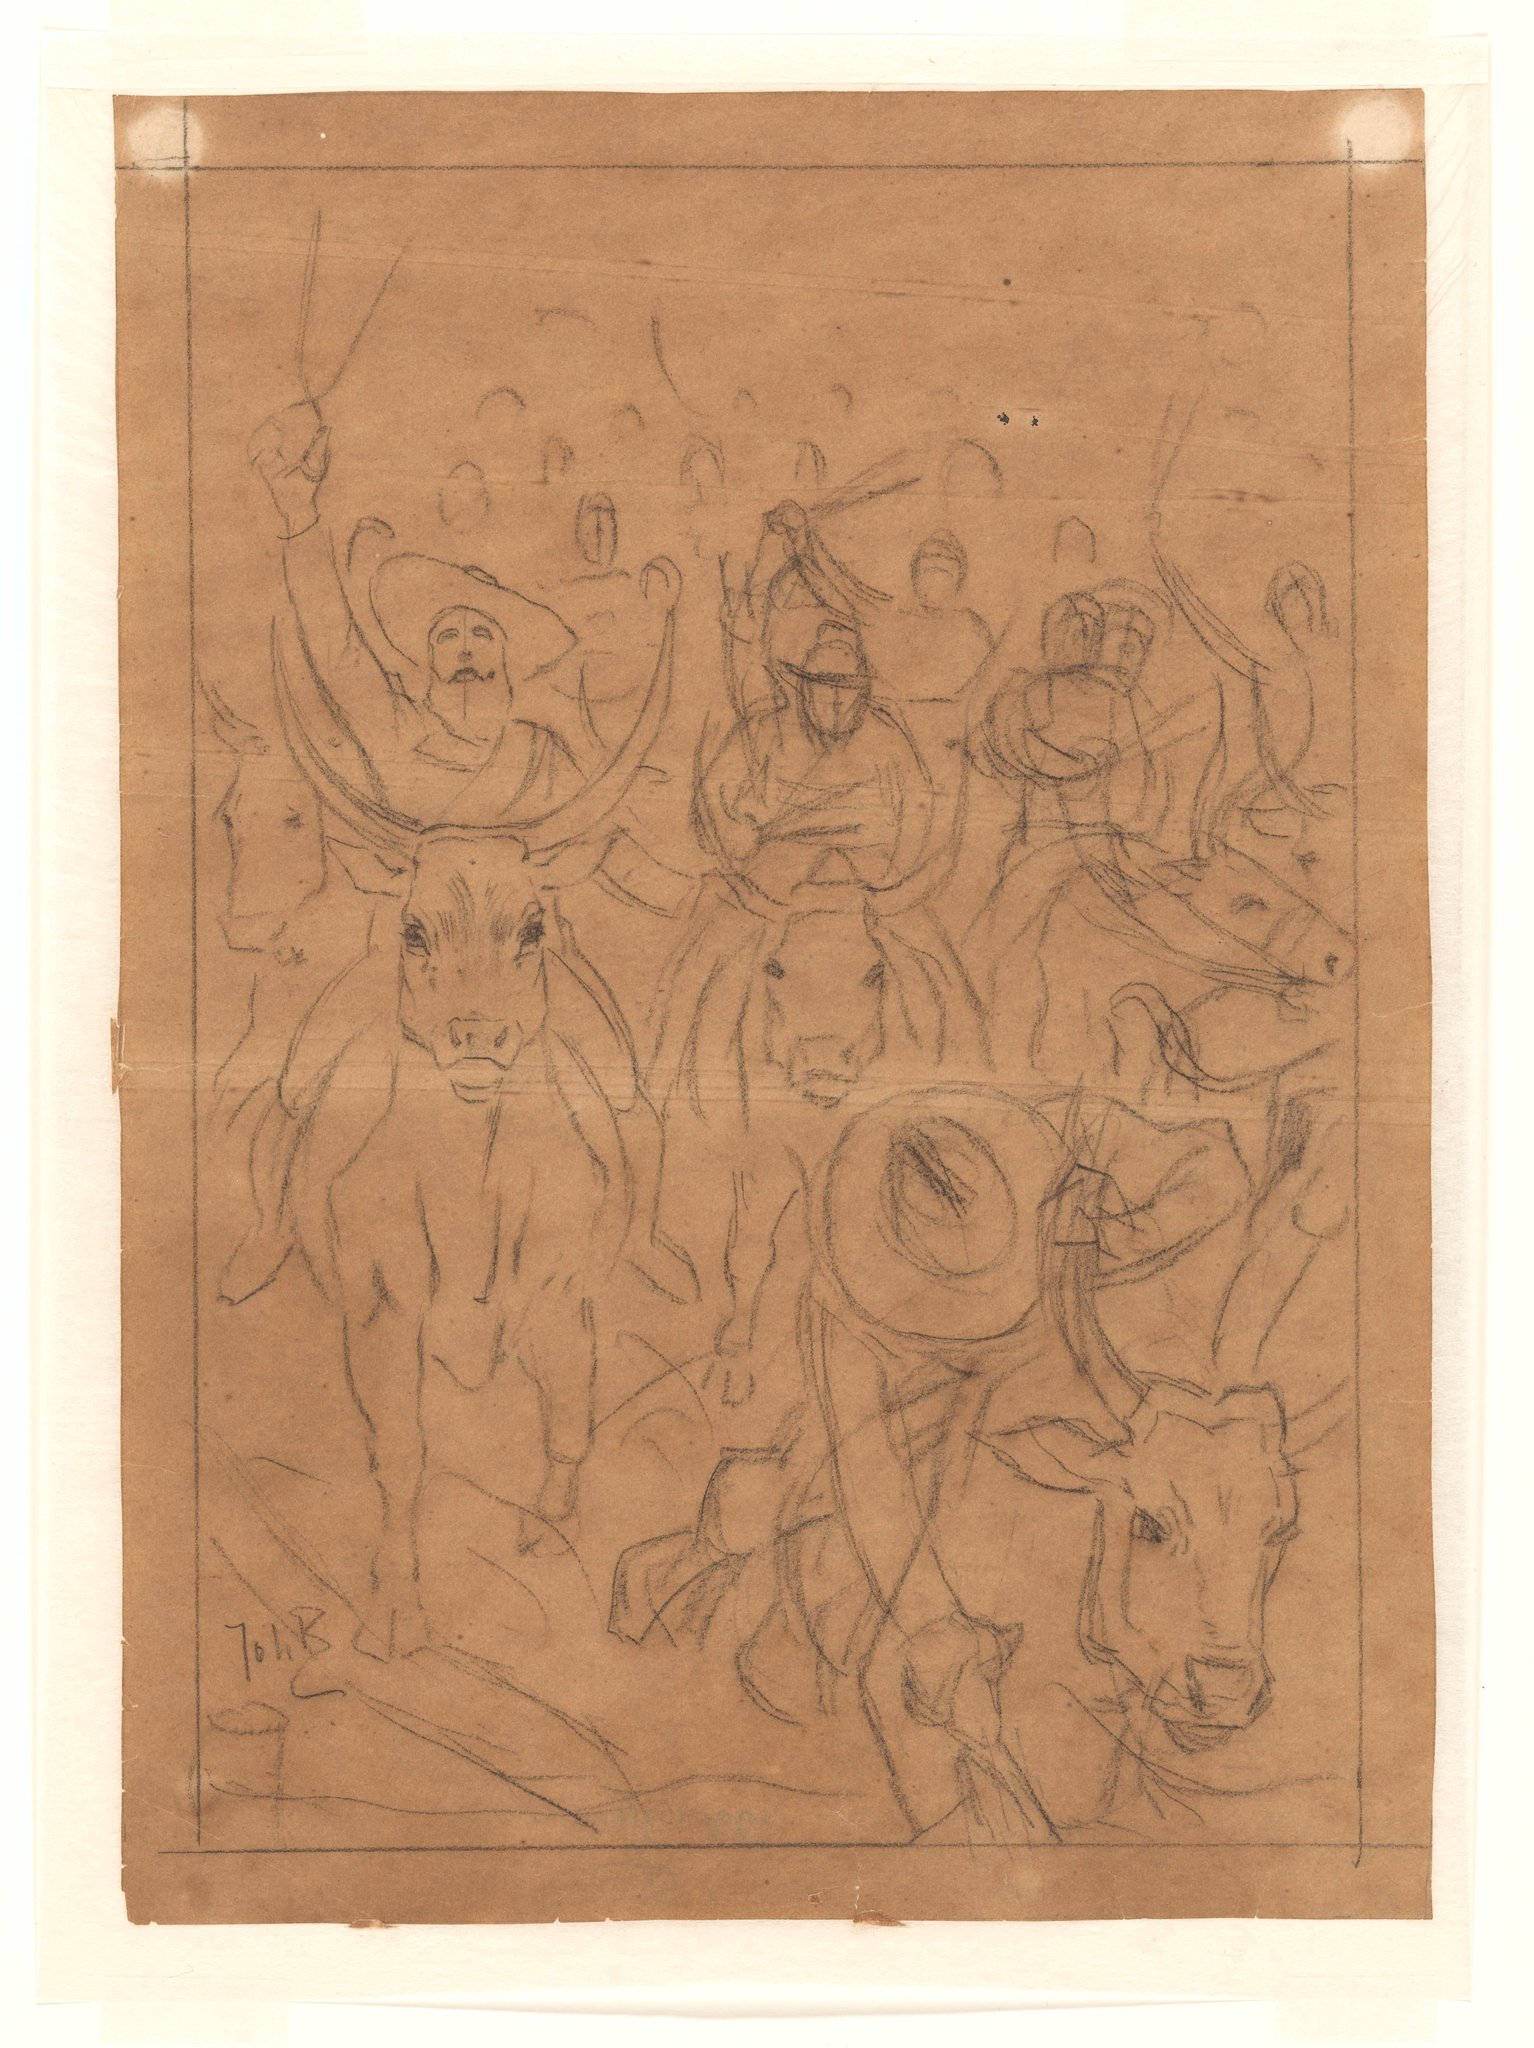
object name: design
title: Ontwerp voor illustratie in De Amsterdammer: Boeren rijdend op koeien (2 Maart 1902)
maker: johan braakensiek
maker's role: draughtsman, print maker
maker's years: 1858-1940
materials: chalk, paper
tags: political caricatures and satires